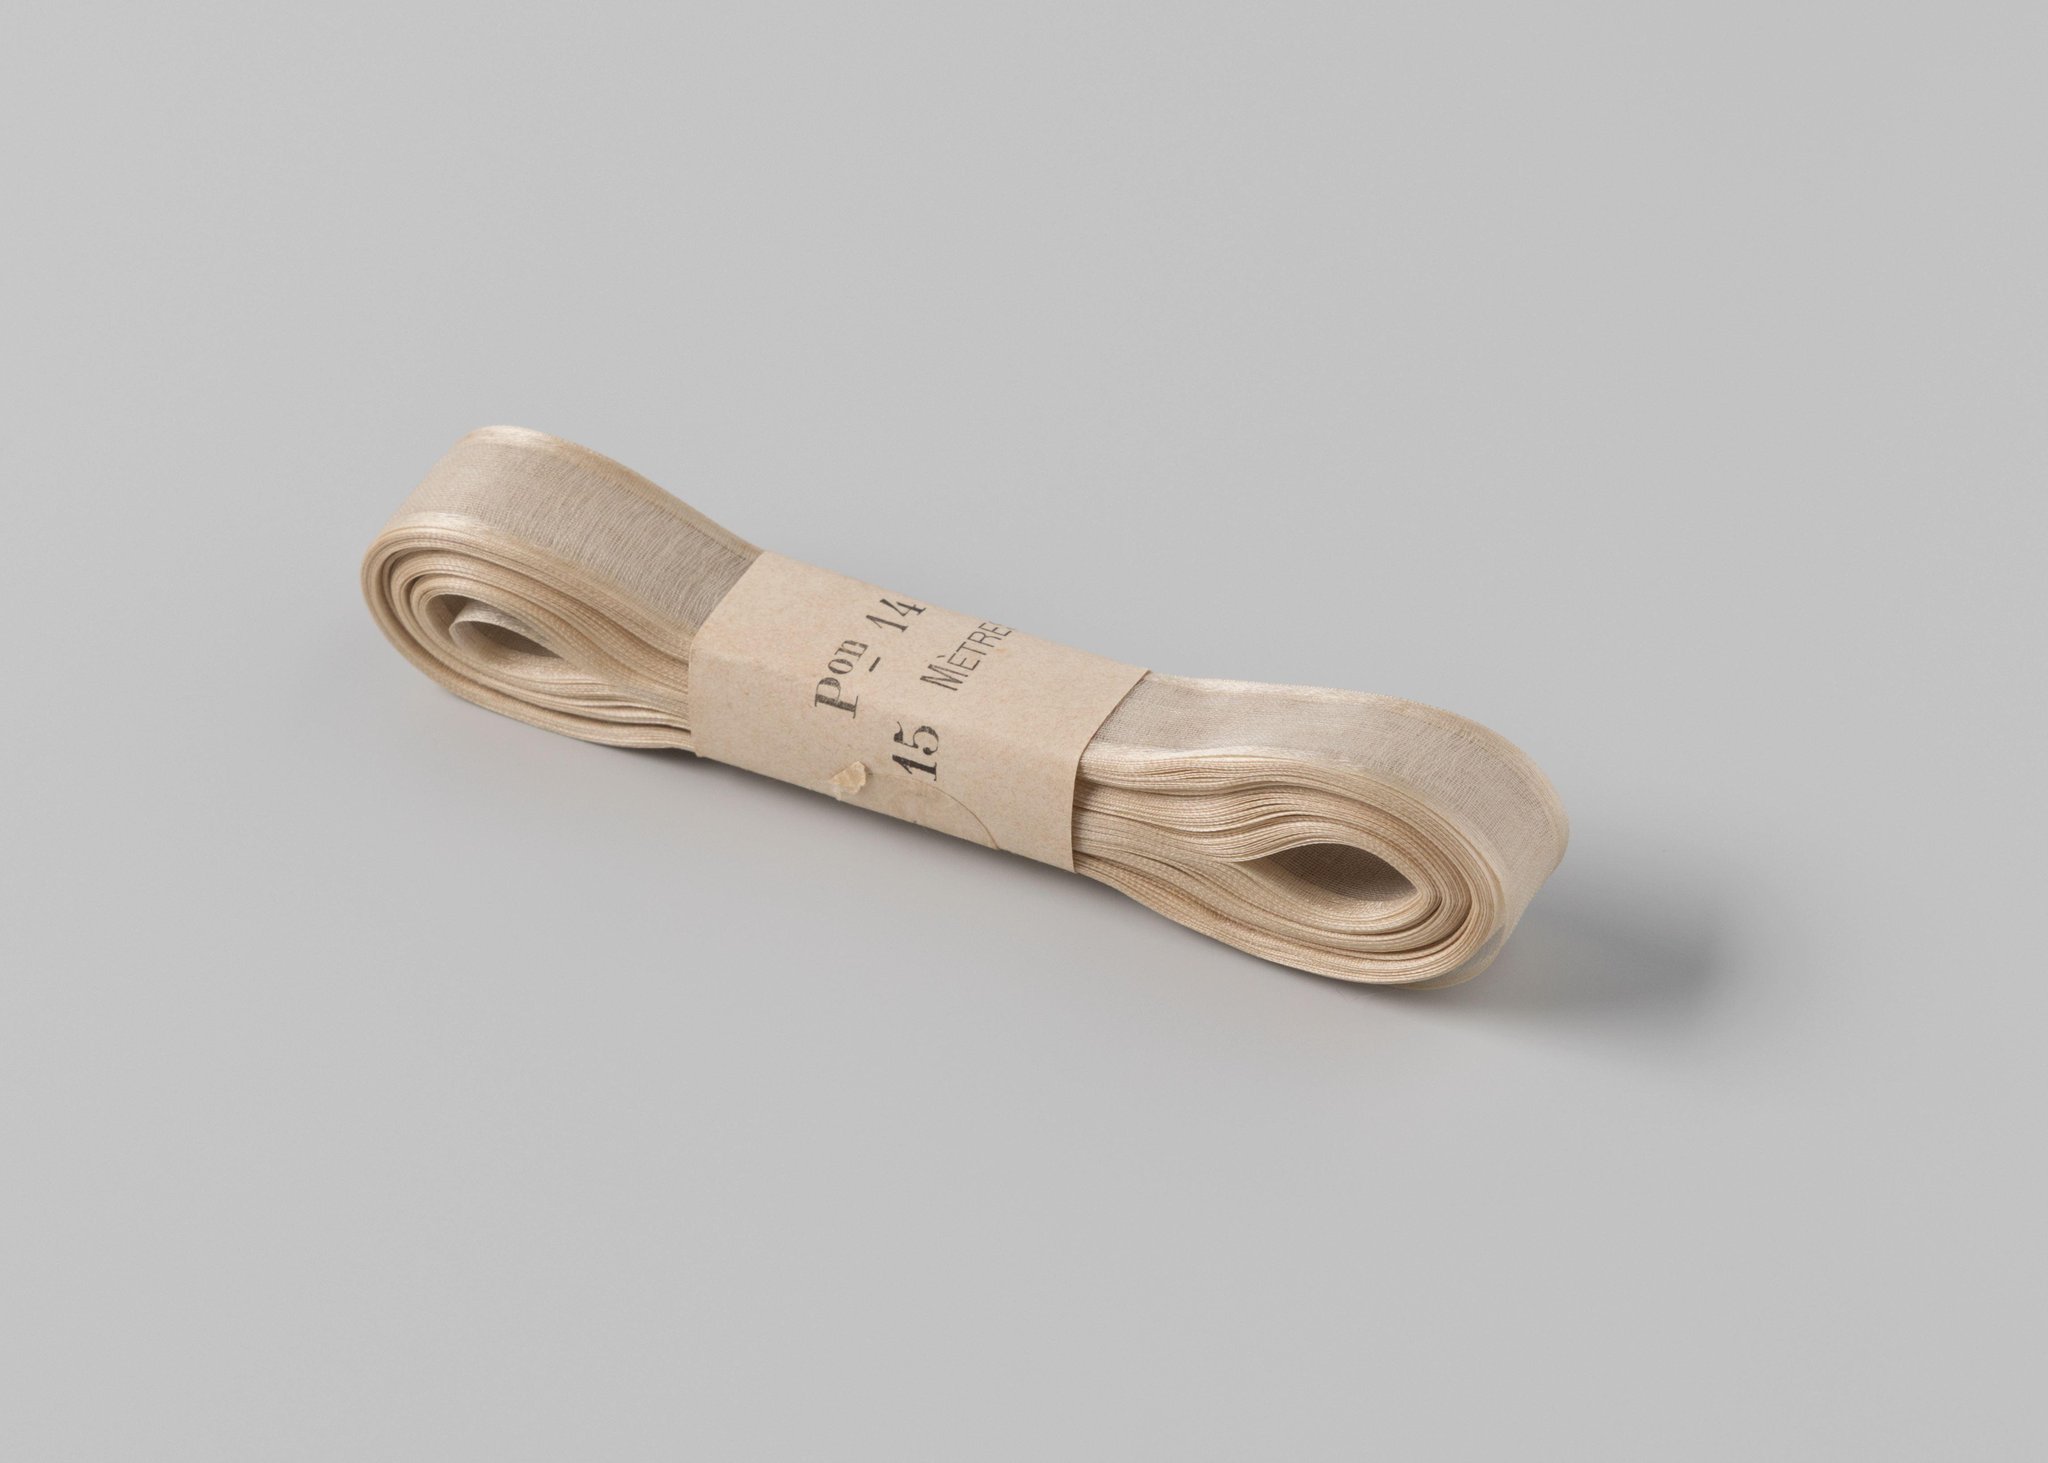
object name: braid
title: Lint van crèmekleurig gaas van 15 meter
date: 1900-1915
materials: textile, silk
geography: nijmegen